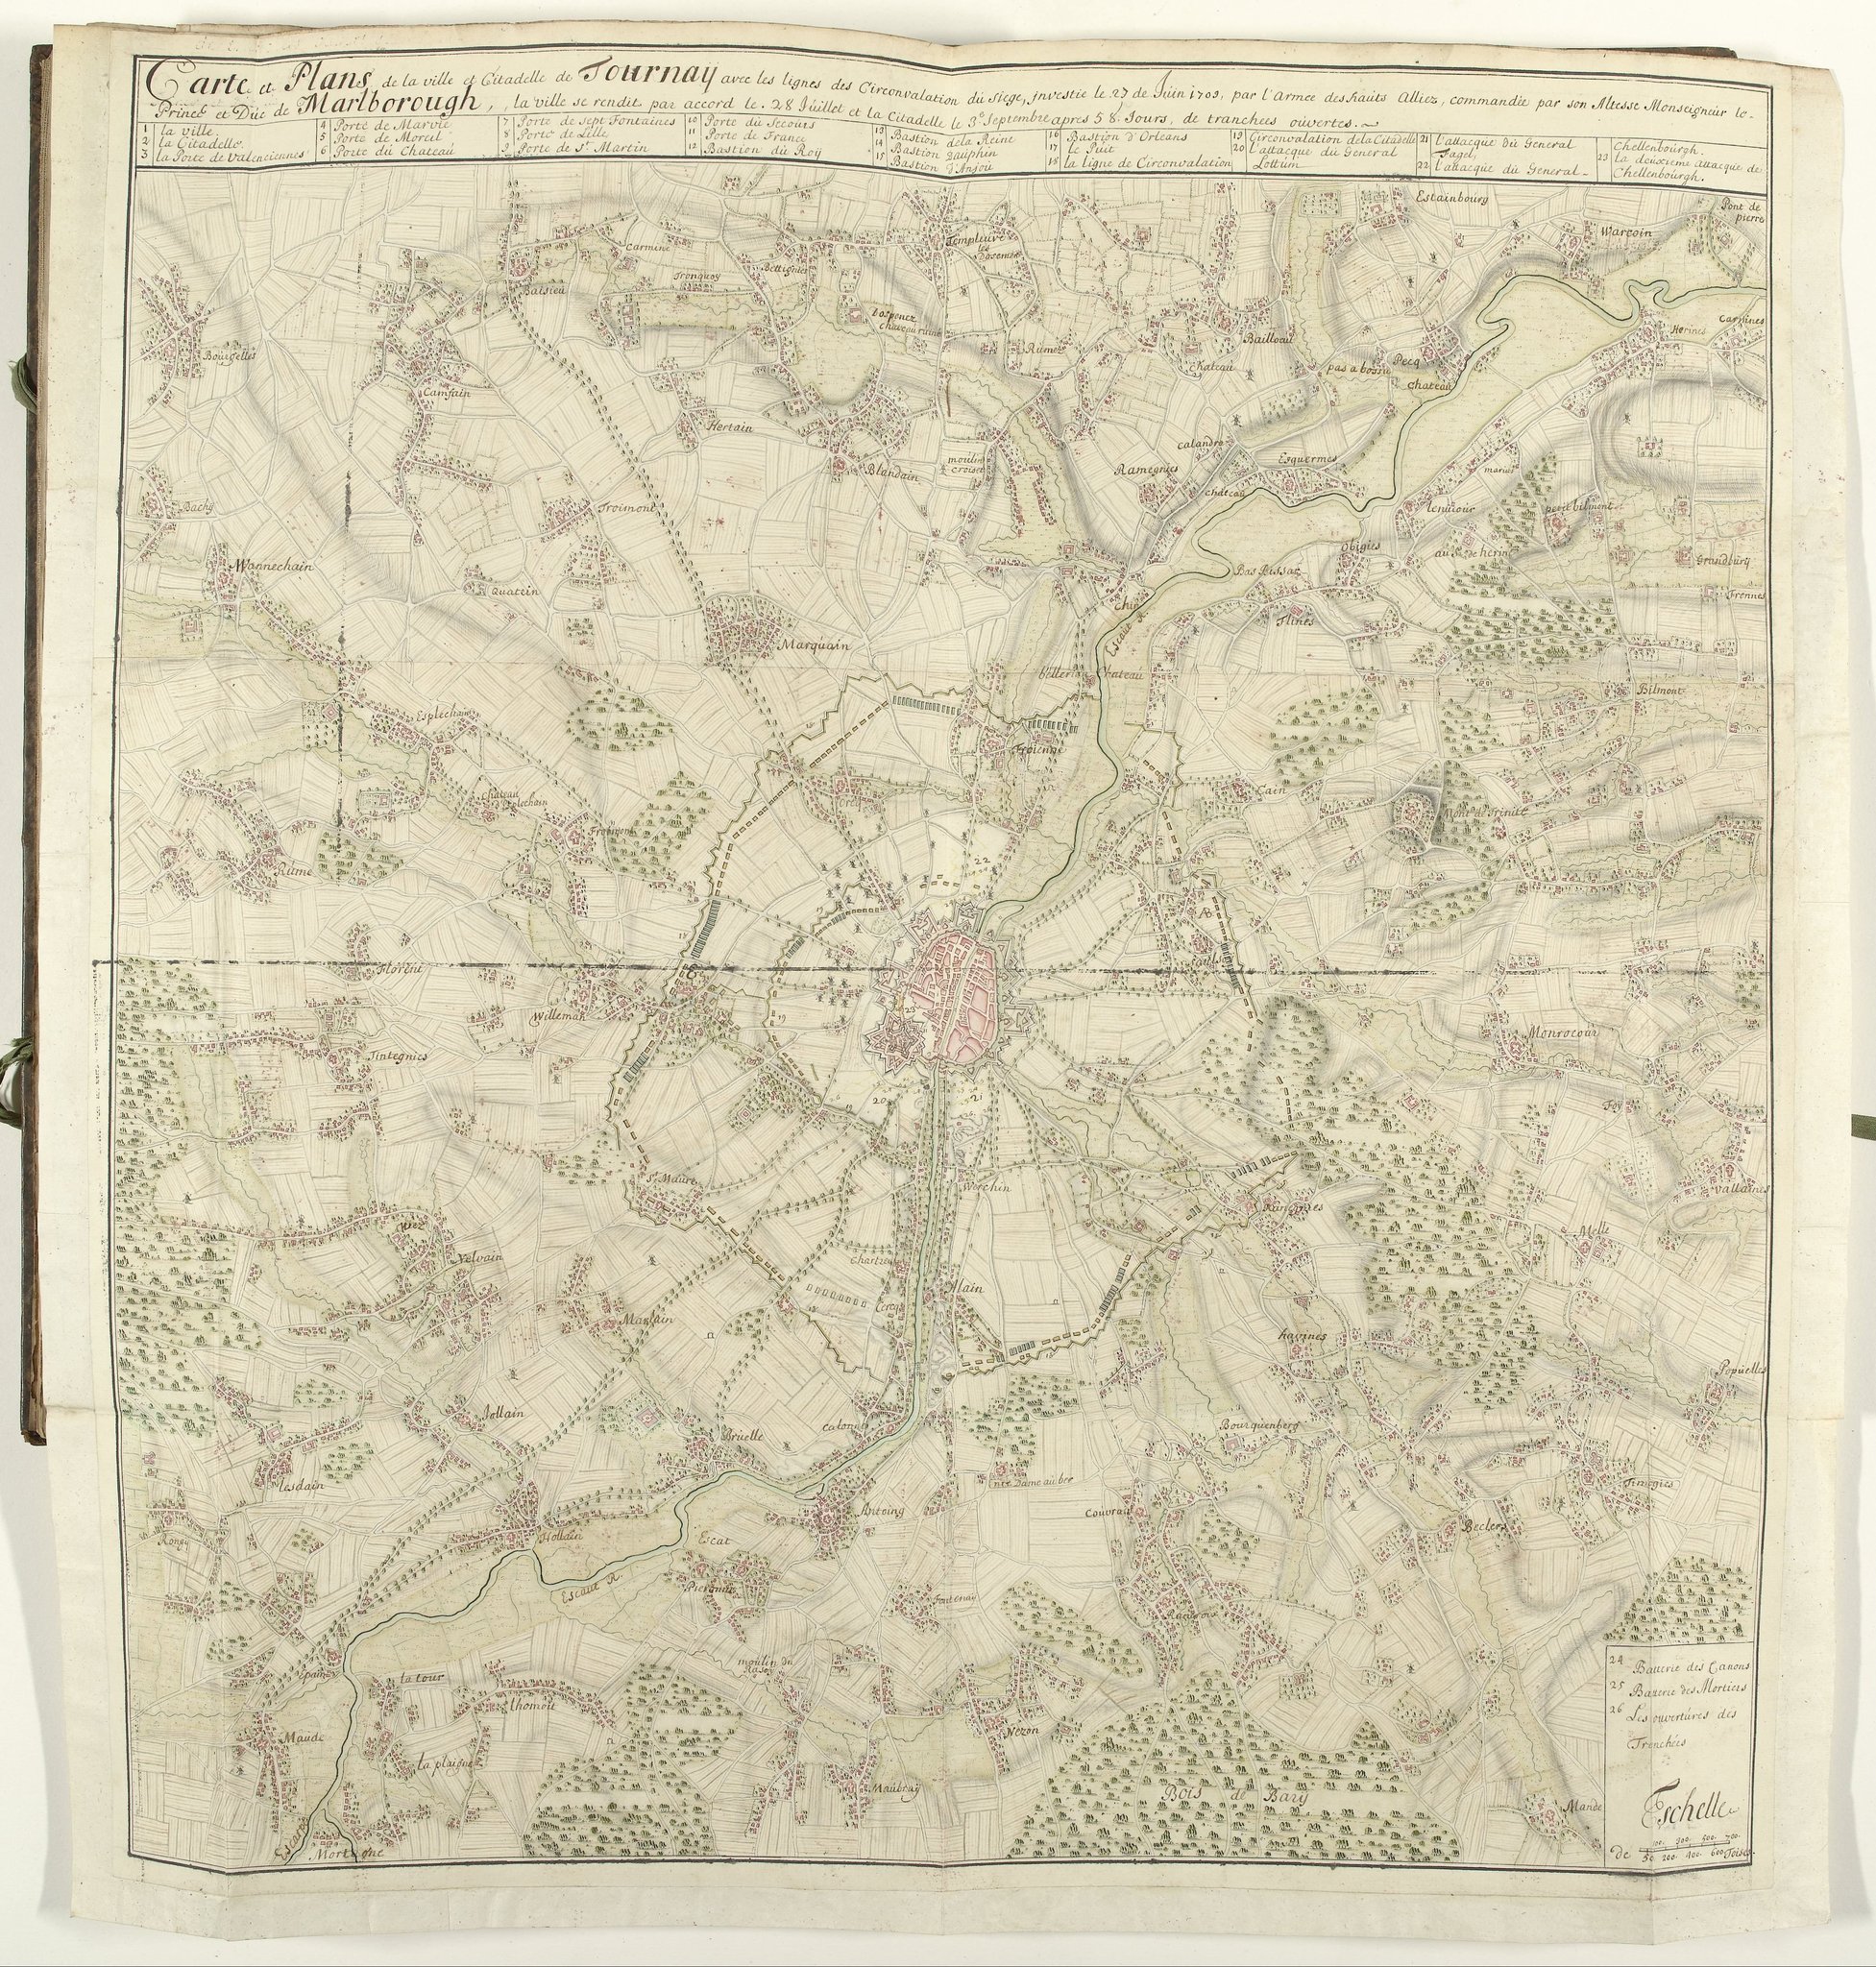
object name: map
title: Carte et Plans de la cille et citadelle de Tournay avec les lignes des Circonvalations du siege, investie le 27 de Juin 1709 (...)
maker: samuel du ry de champdoré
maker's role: draughtsman, engineer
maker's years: 1651-1729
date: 1709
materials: paper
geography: netherlands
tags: john churchill (1e hertog van marlborough), maps of separate countries or regions, siege, position war, maps of cities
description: Kaart van Tournai (Doornik) en omgeving, belegerd door de Geallieerden onder de hertog van Marlborough vanaf 29 juni en ingenomen op 2 september 1709. Bovenaan en rechtsonder de legenda 1-26 in het Frans. Onderdeel van een verzameling getekende plannen van versterkte plaatsen in Nederland en omringende landen ten tijde van de Spaanse Successieoorlog (deel C).